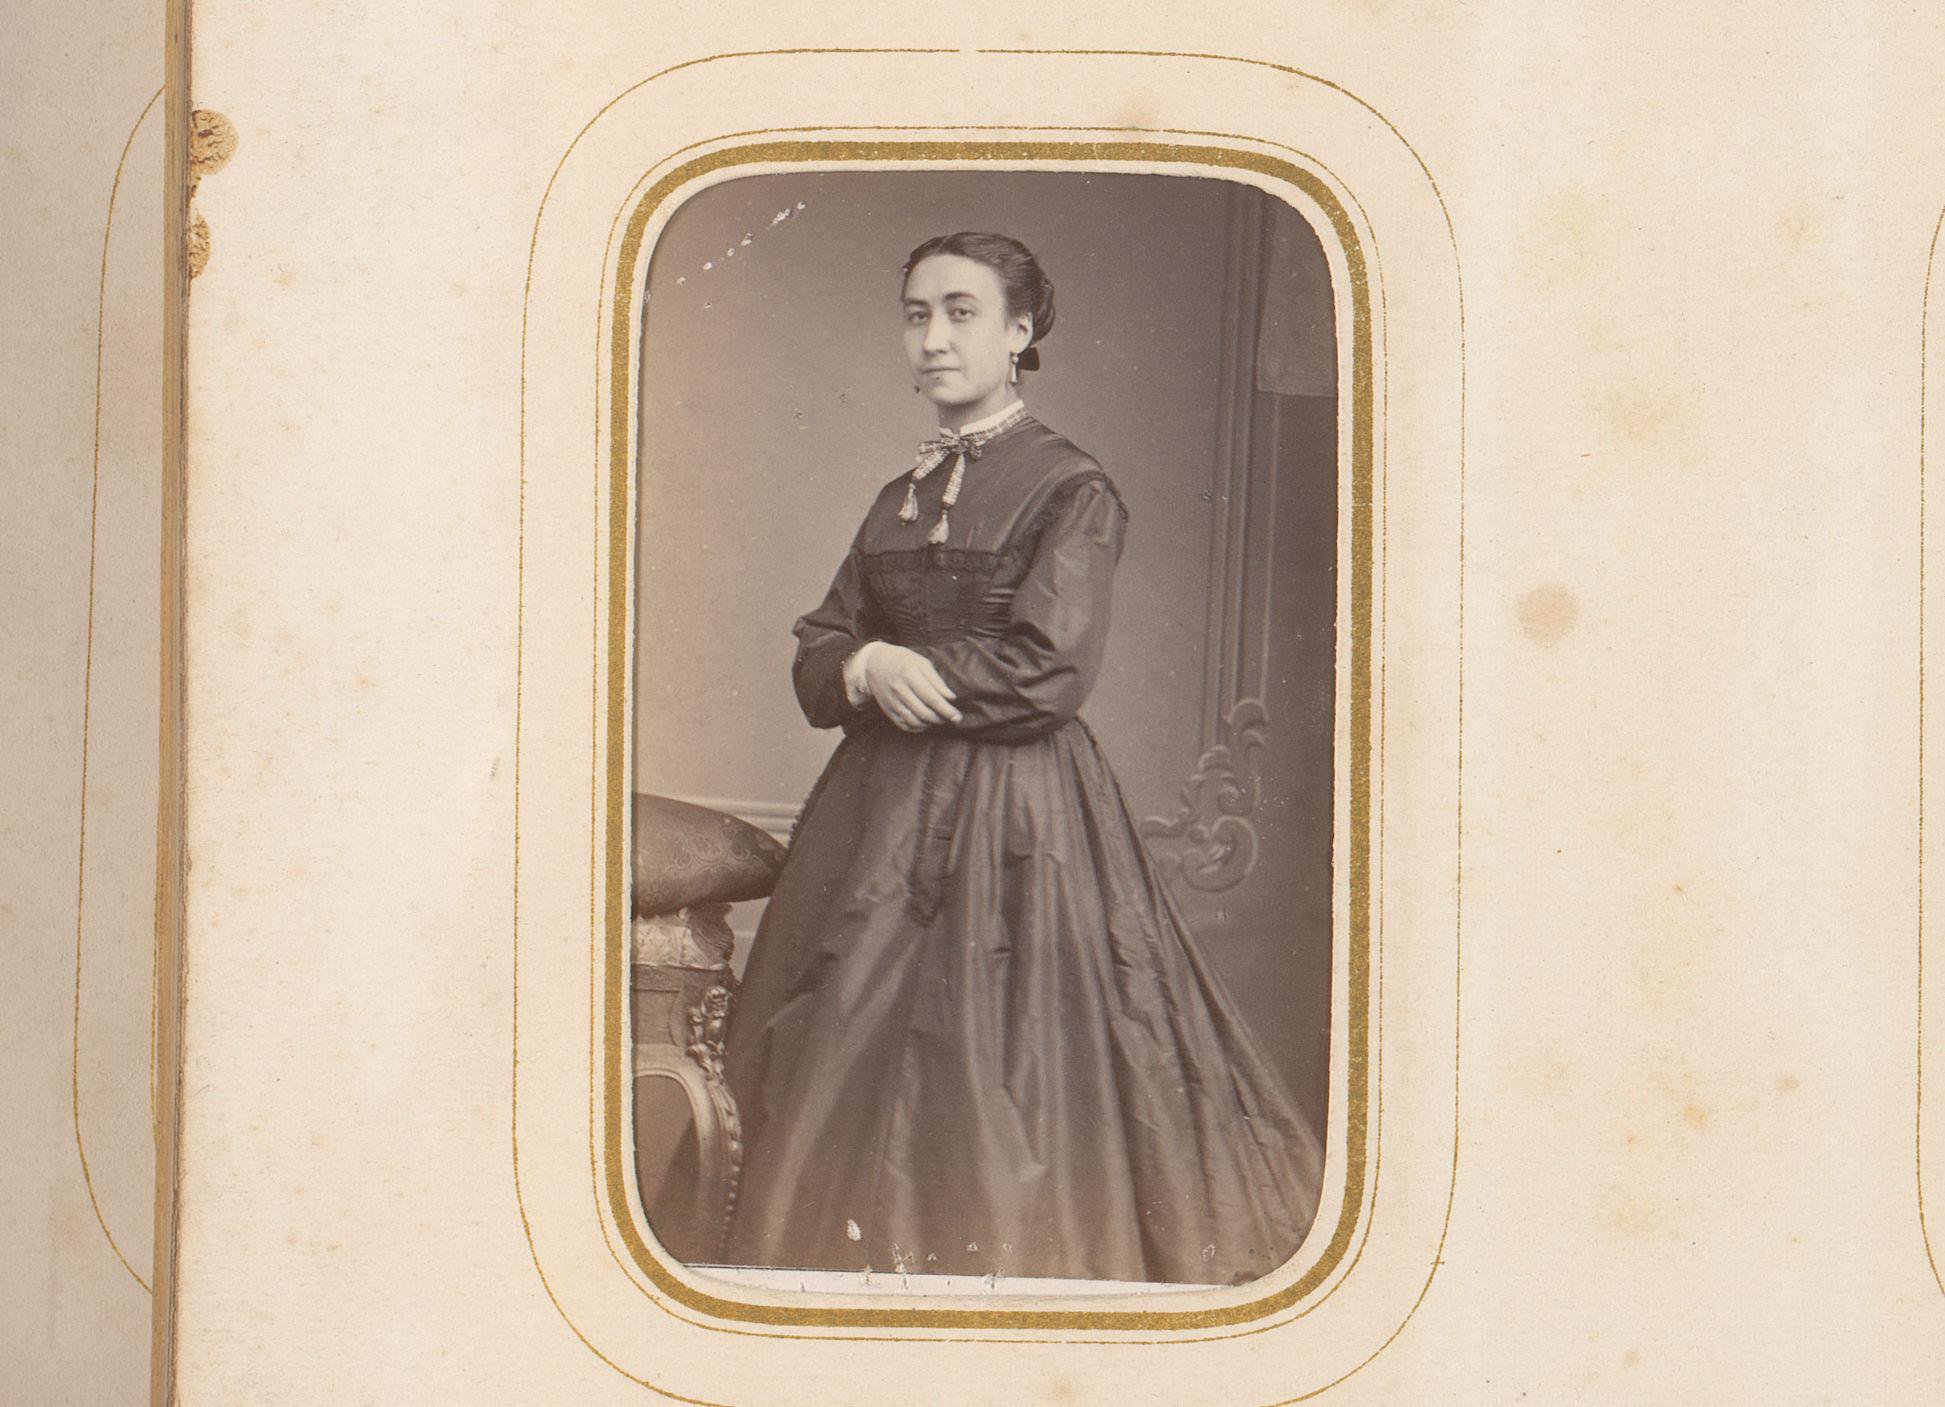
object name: photograph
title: Portret van een staande vrouw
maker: auguste berthon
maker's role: painter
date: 1860-1890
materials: cardboard, photographic support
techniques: albumen print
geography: saint-étienne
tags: historical persons - bb - woman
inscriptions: inscription: ‘Berthon Auguste/ Peintre & Photographe/ Place Mi-Carème, 4/ St. Etienne’, inscription: ‘Berthon Auguste’